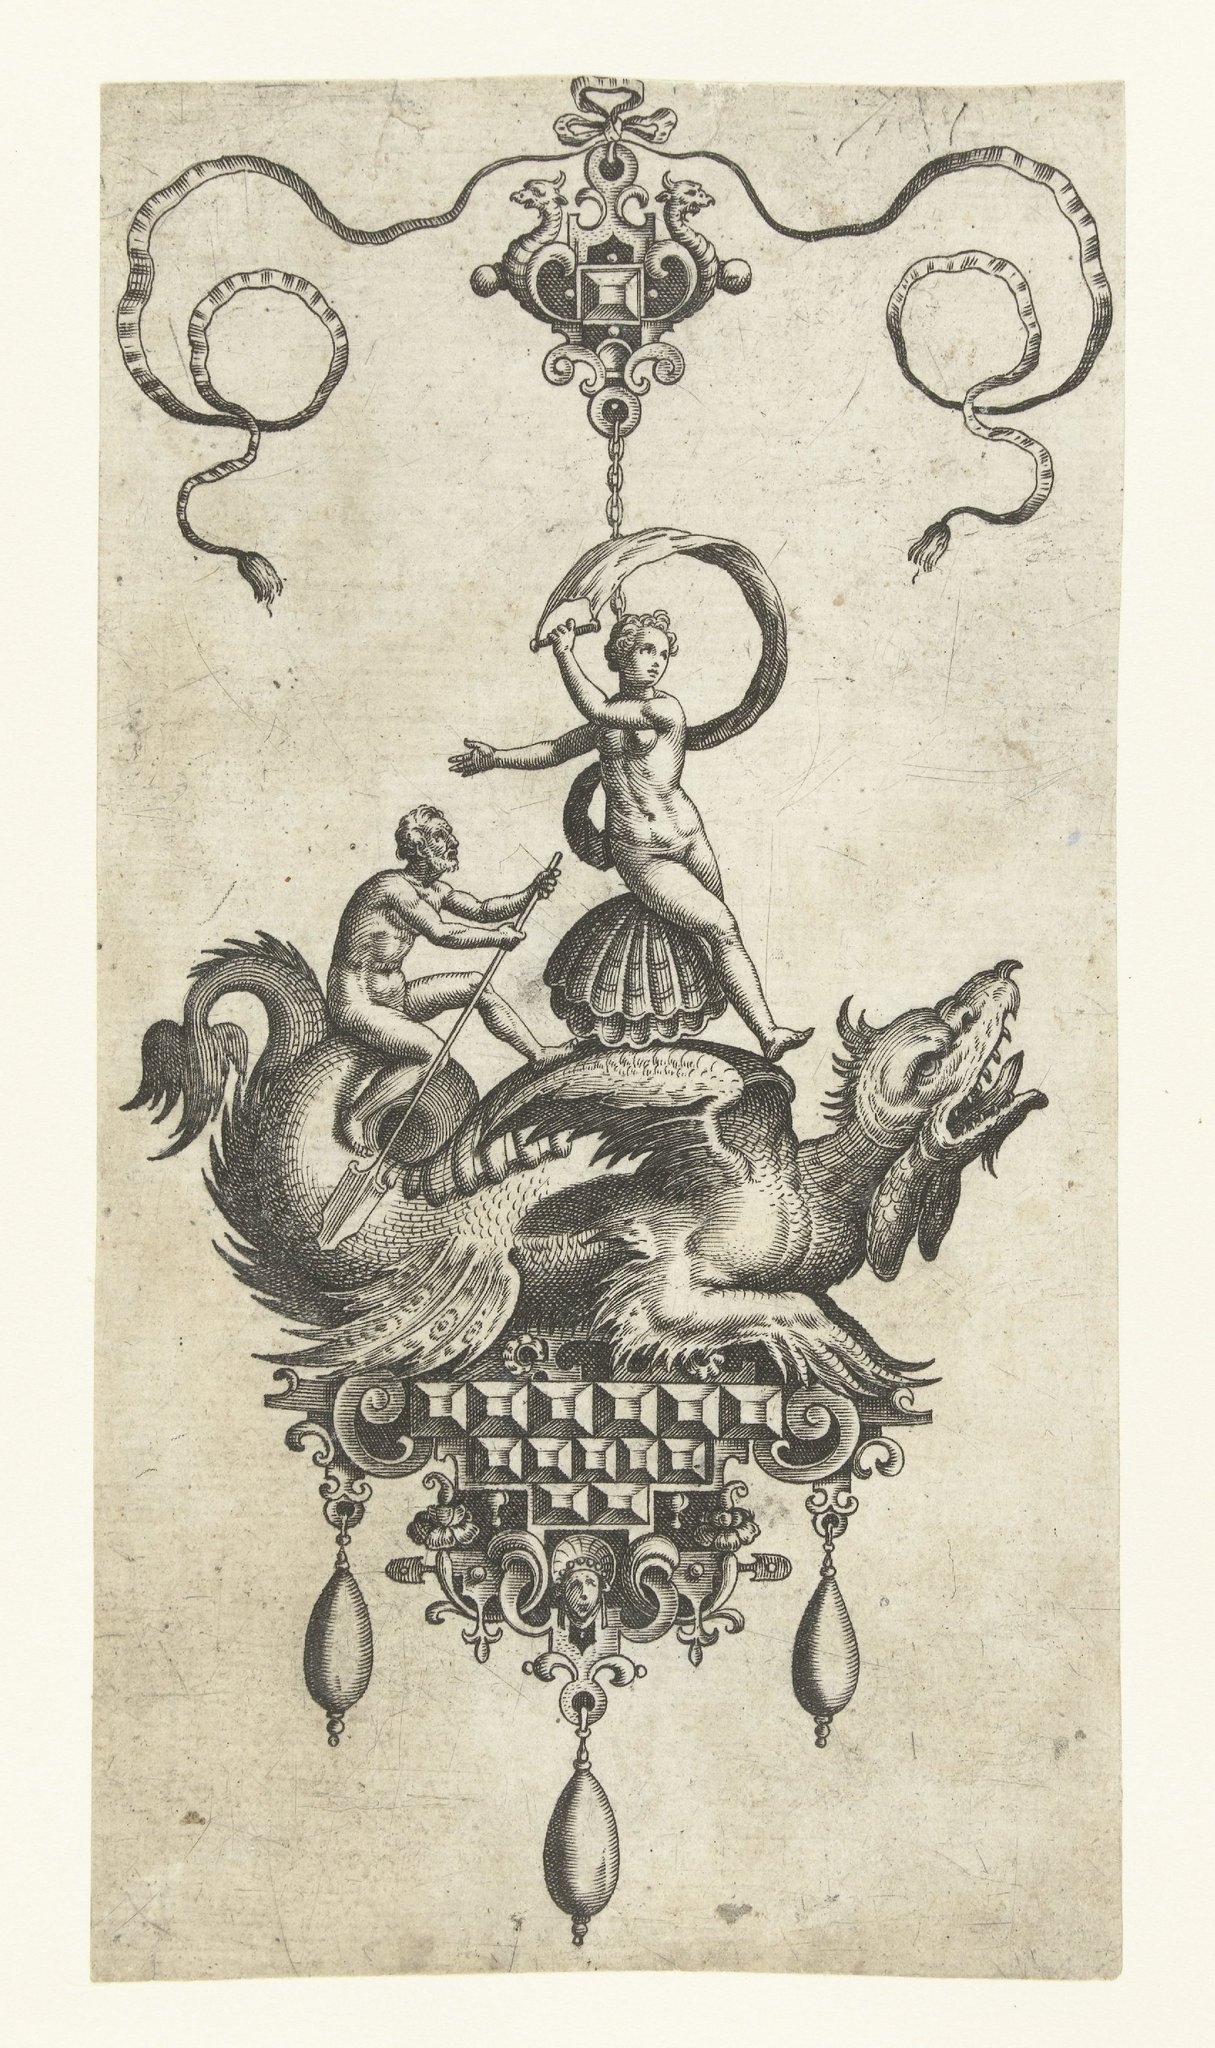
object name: print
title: Copie van de tegenzijde van N( 9 der vorige suite (zie RP-P-1894-A-18382)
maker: Anonymous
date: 1530-1581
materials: paper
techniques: engraving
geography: netherlands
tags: 'pistrix', sea-dragon, pendant, trinket, 'breloque', birth of venus; venus anadyomene: after uranus' castration venus rises from the sea wringing the water from her hair; usually she is awaited by the hours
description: Op de schelp zit Venus Anadyomene. Op de staart van de draak zit een man met een roeispaan.Tegenzijdige kopie van RP-P-1894-A-18382.